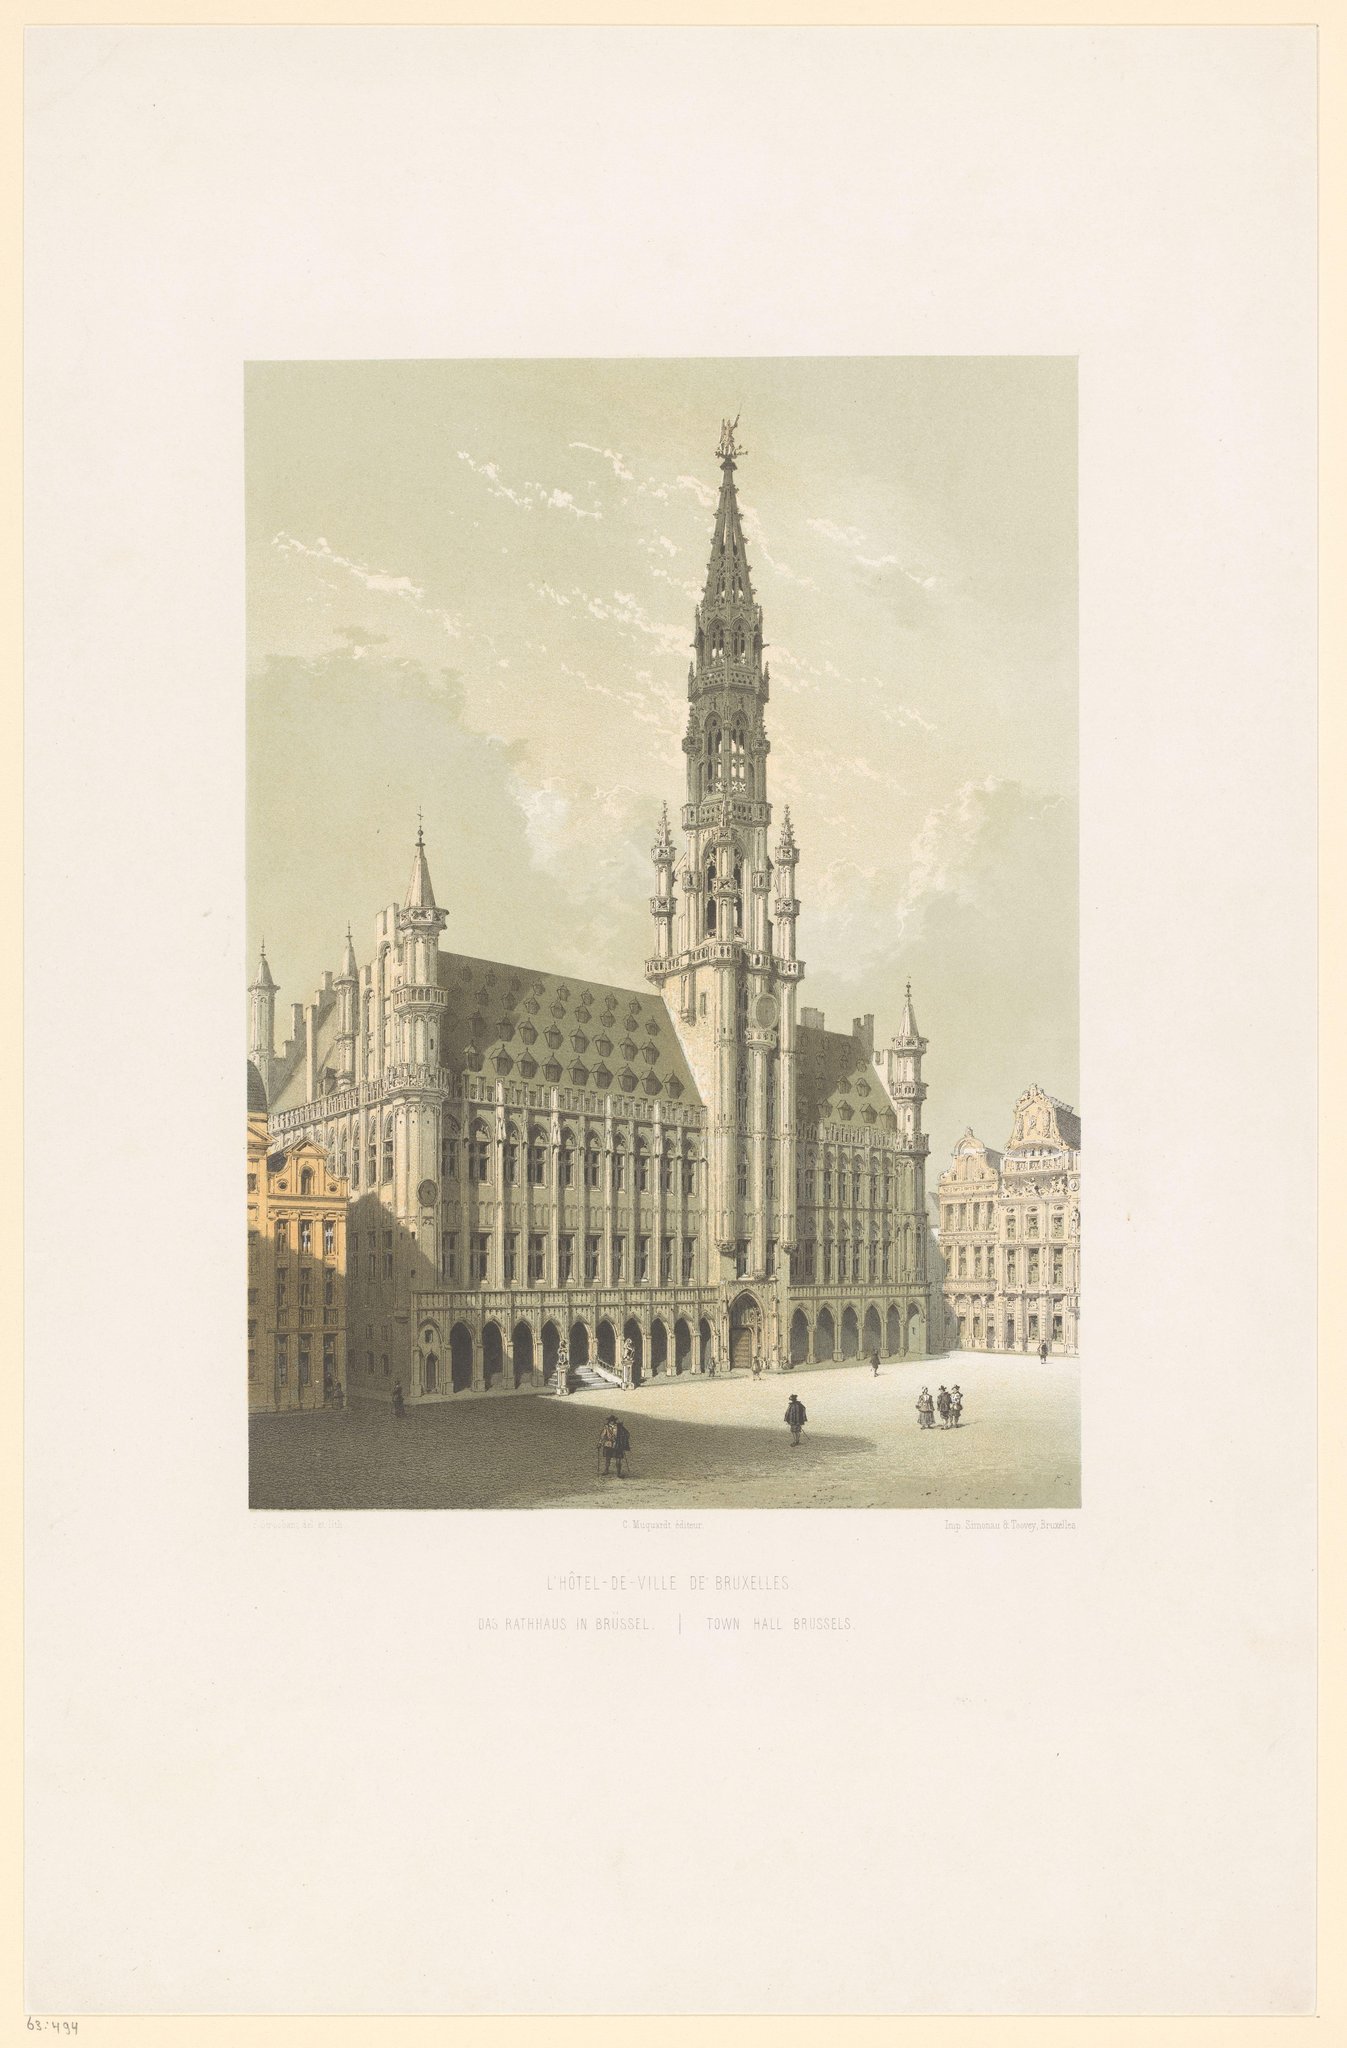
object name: print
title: Stadhuis te Brussel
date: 1852-1878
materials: paper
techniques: lithograph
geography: brussels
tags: townhall, civic architecture; edifices; dwellings, city-view in general; 'veduta' (+ city(-scape) with figures, staffage)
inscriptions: collector's mark: Lugt 2760, collector's mark: Lugt 2228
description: Vanaf 1852 verschijnen de eerste afleveringen van deze serie, telkens in een set van drie platen voorzien van tekst door Félix Stappaerts. Later (vanaf 1854 tot en met 1878) worden deze prenten gebonden uitgegeven.